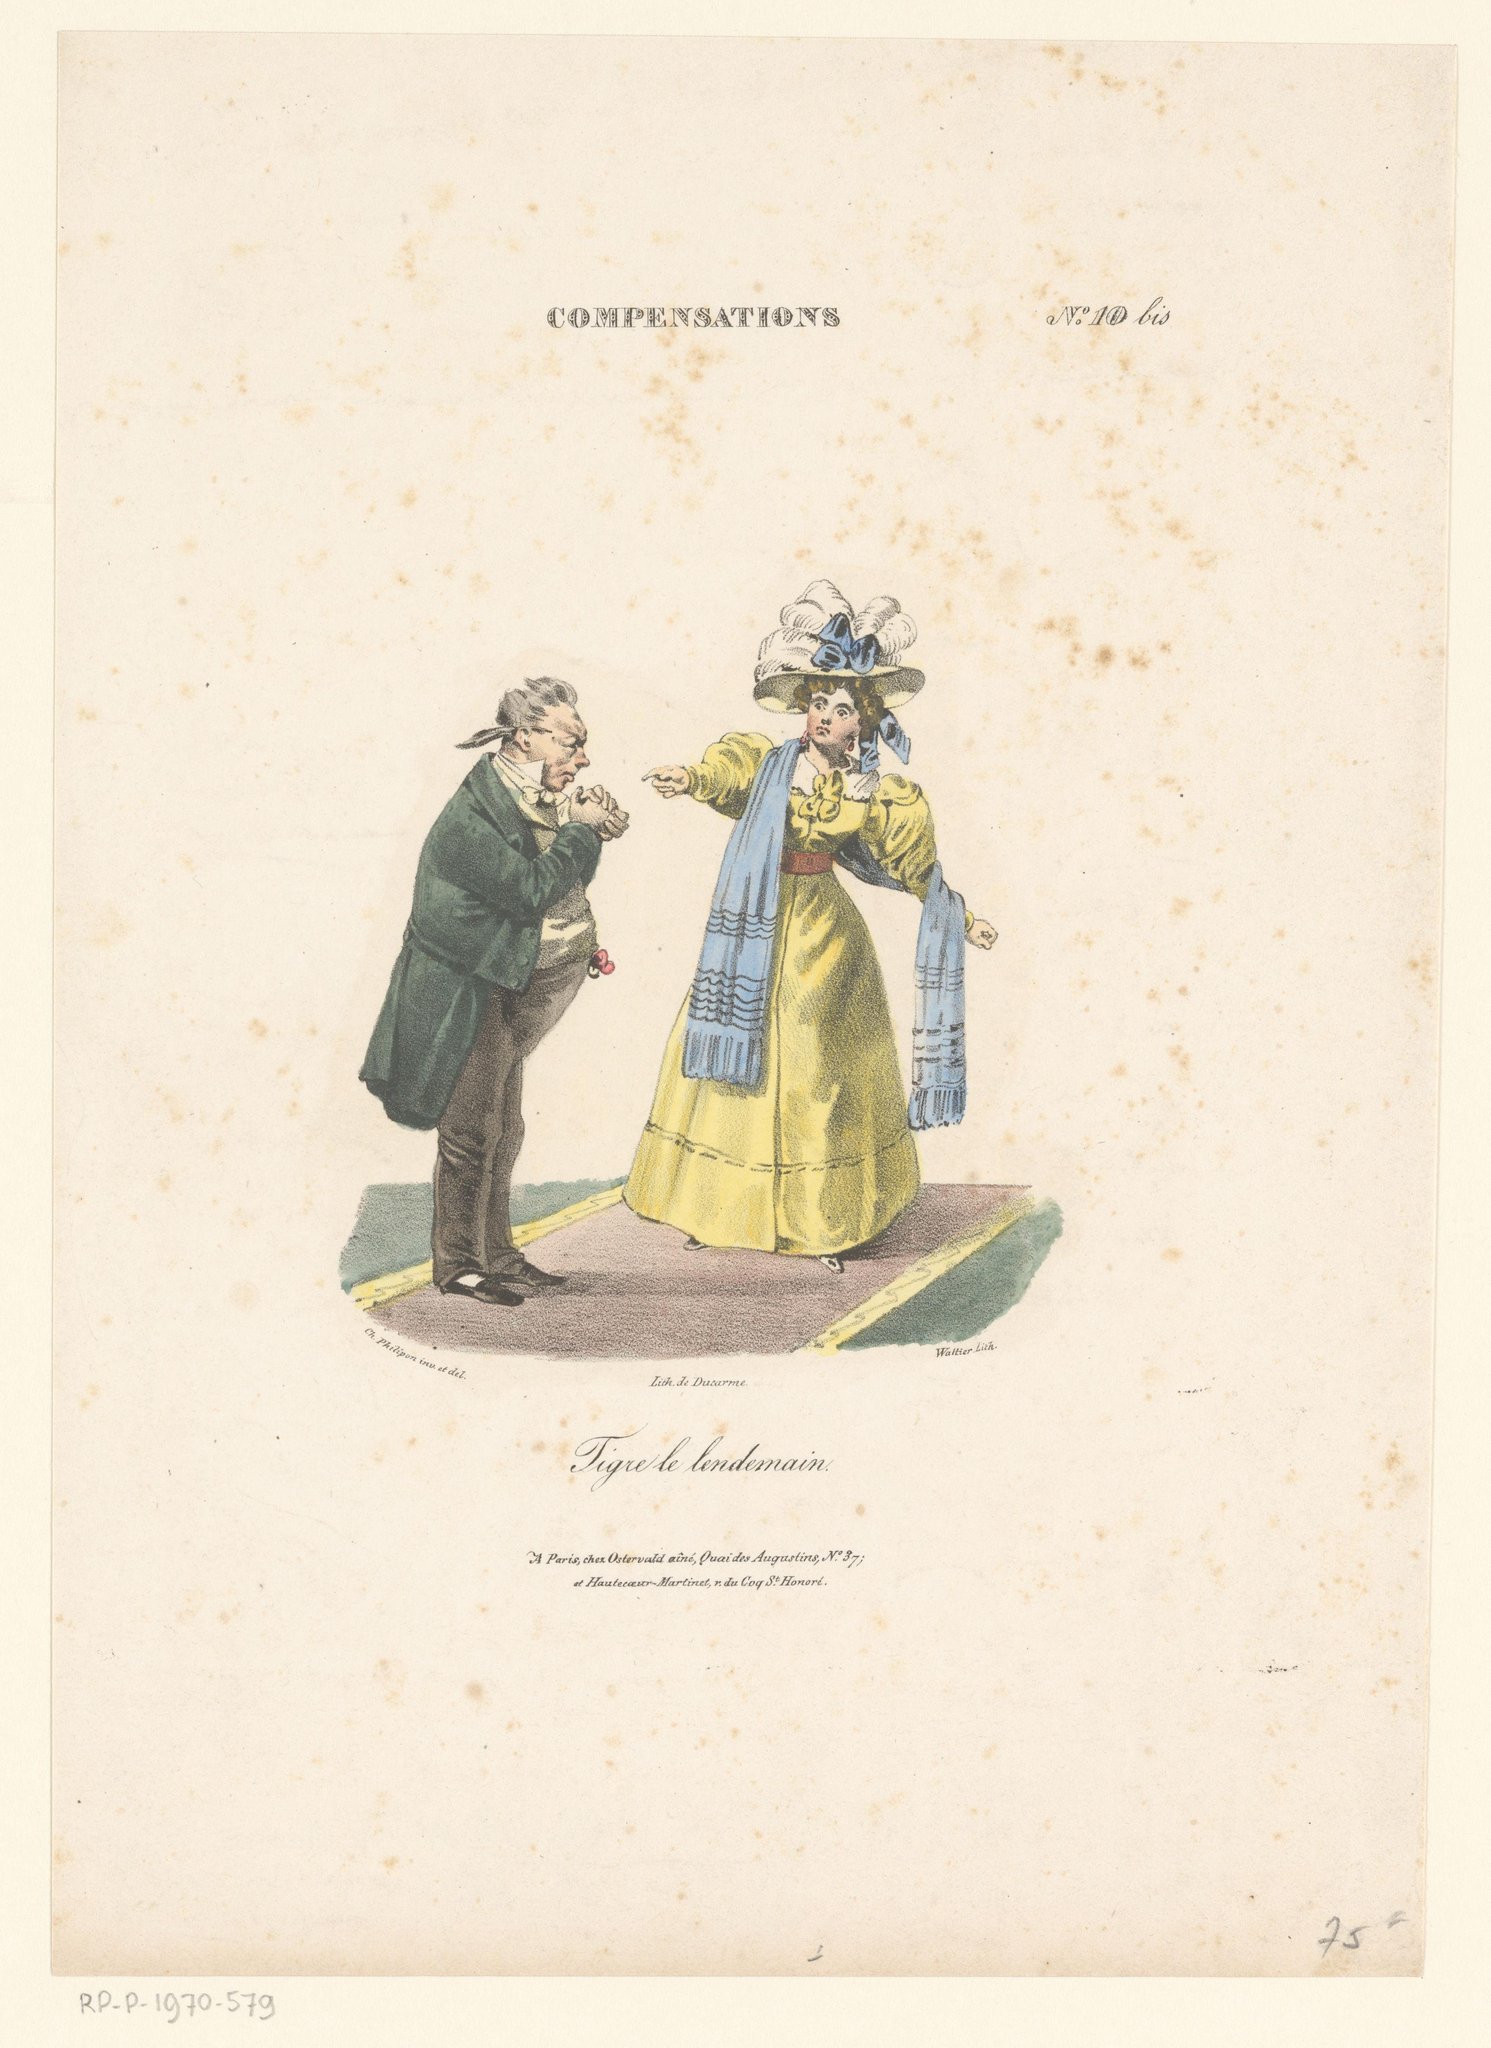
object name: print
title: Vrouw wijst naar man en kijkt verschrikt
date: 1827-1829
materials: paper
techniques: hand coloring, lithograph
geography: paris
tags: fashion, clothing, adult woman, adult man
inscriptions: collector's mark: Lugt 2228, inscription: ‘Paul Prouté, 74 Rue de Seine/ 30 Dec. 1964. N.F. 2,- (3 stuks)’